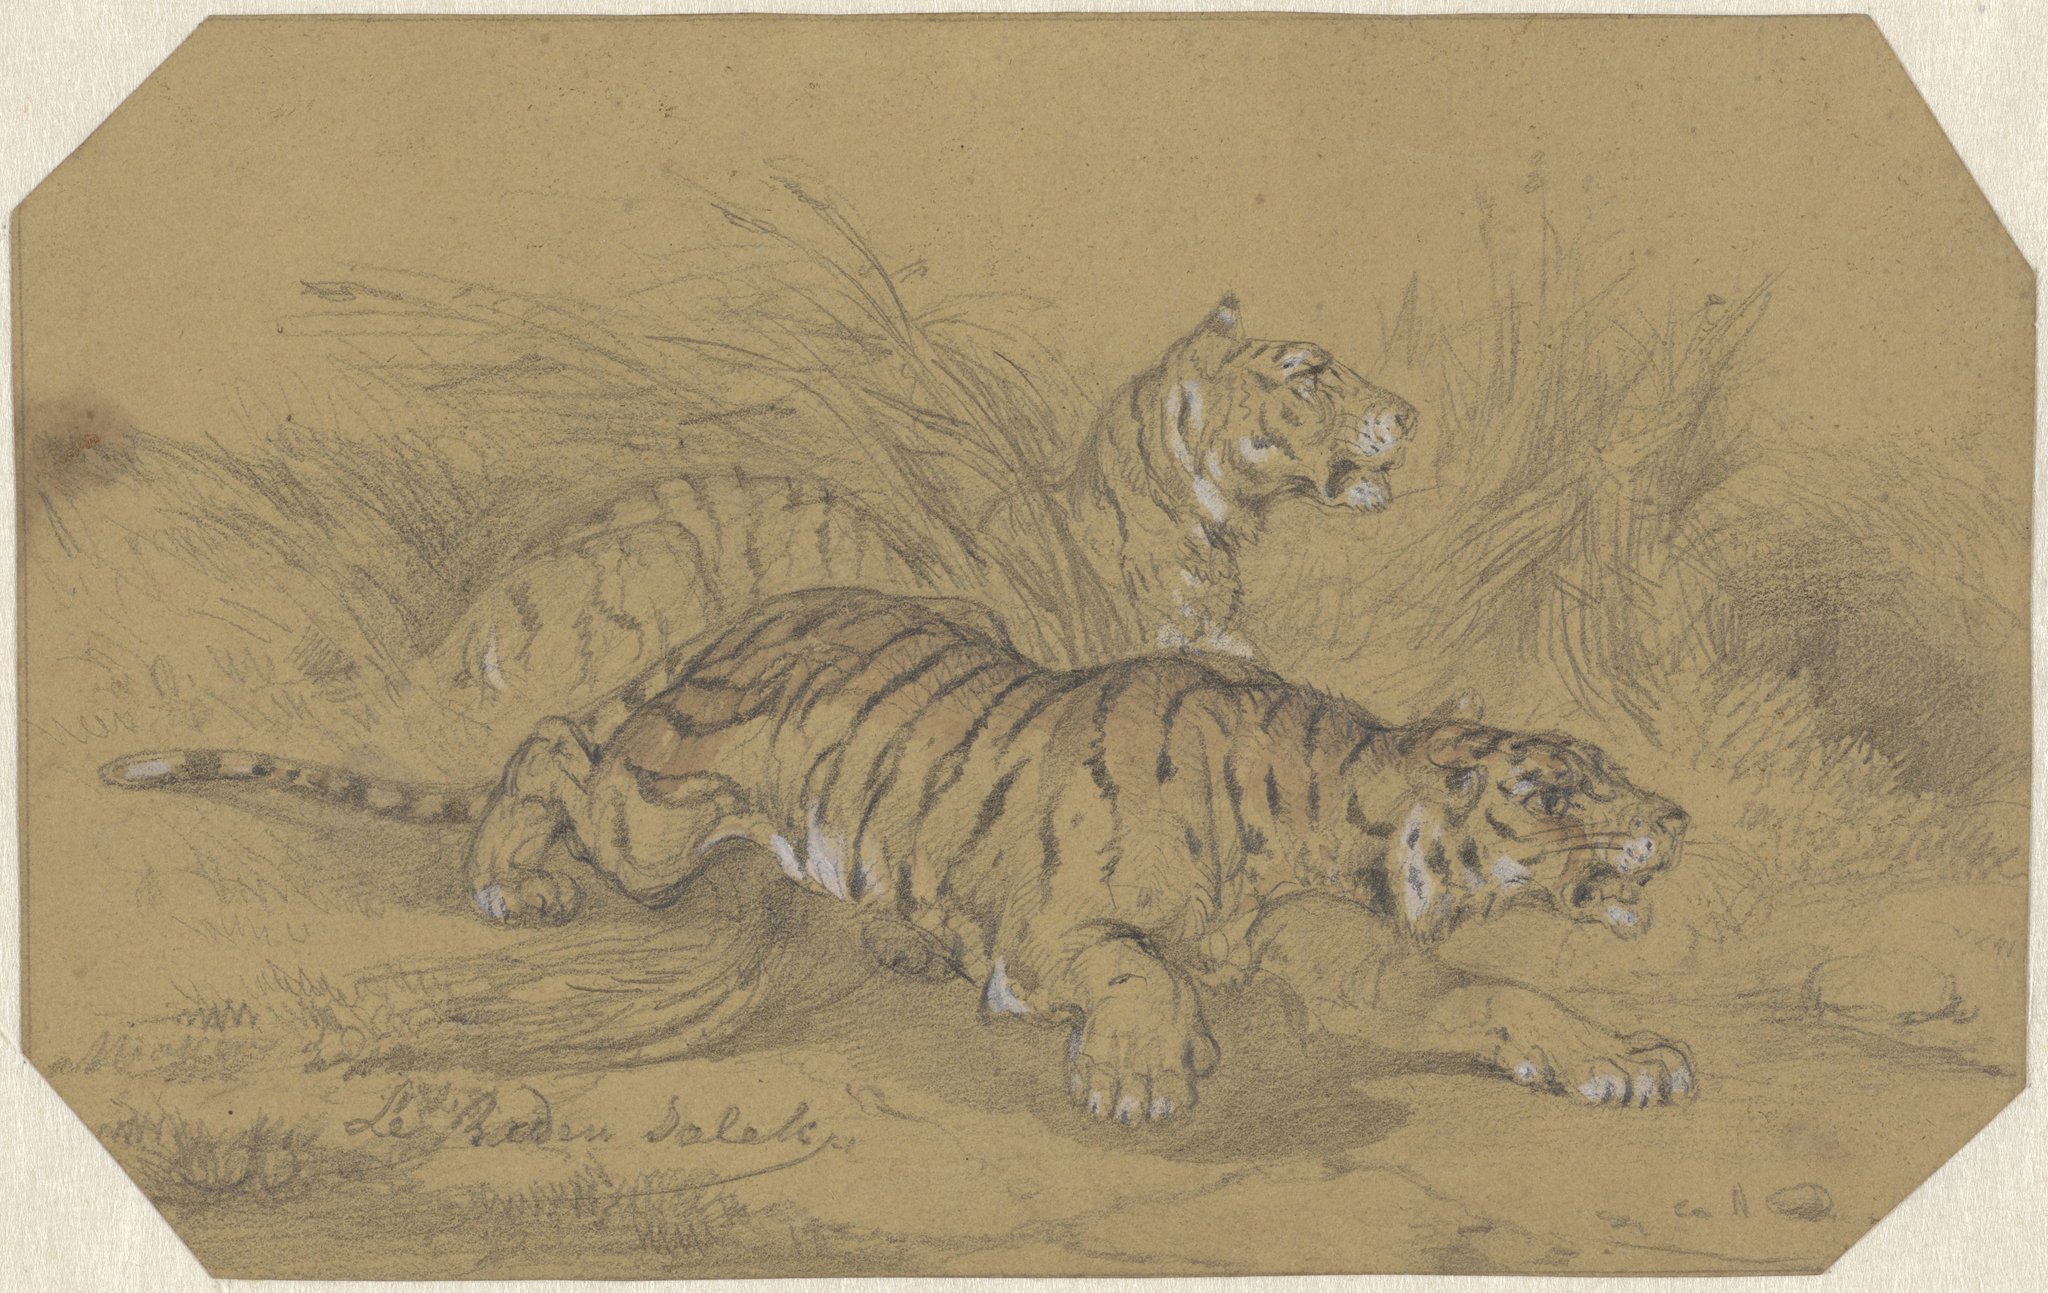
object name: drawing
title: Twee tijgers sluipend door het gras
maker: raden sarief bastaman saleh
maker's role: draughtsman, painter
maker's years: 1814-1880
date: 1824-1880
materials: paper, pencil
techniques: brush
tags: beasts of prey, predatory animals: tiger